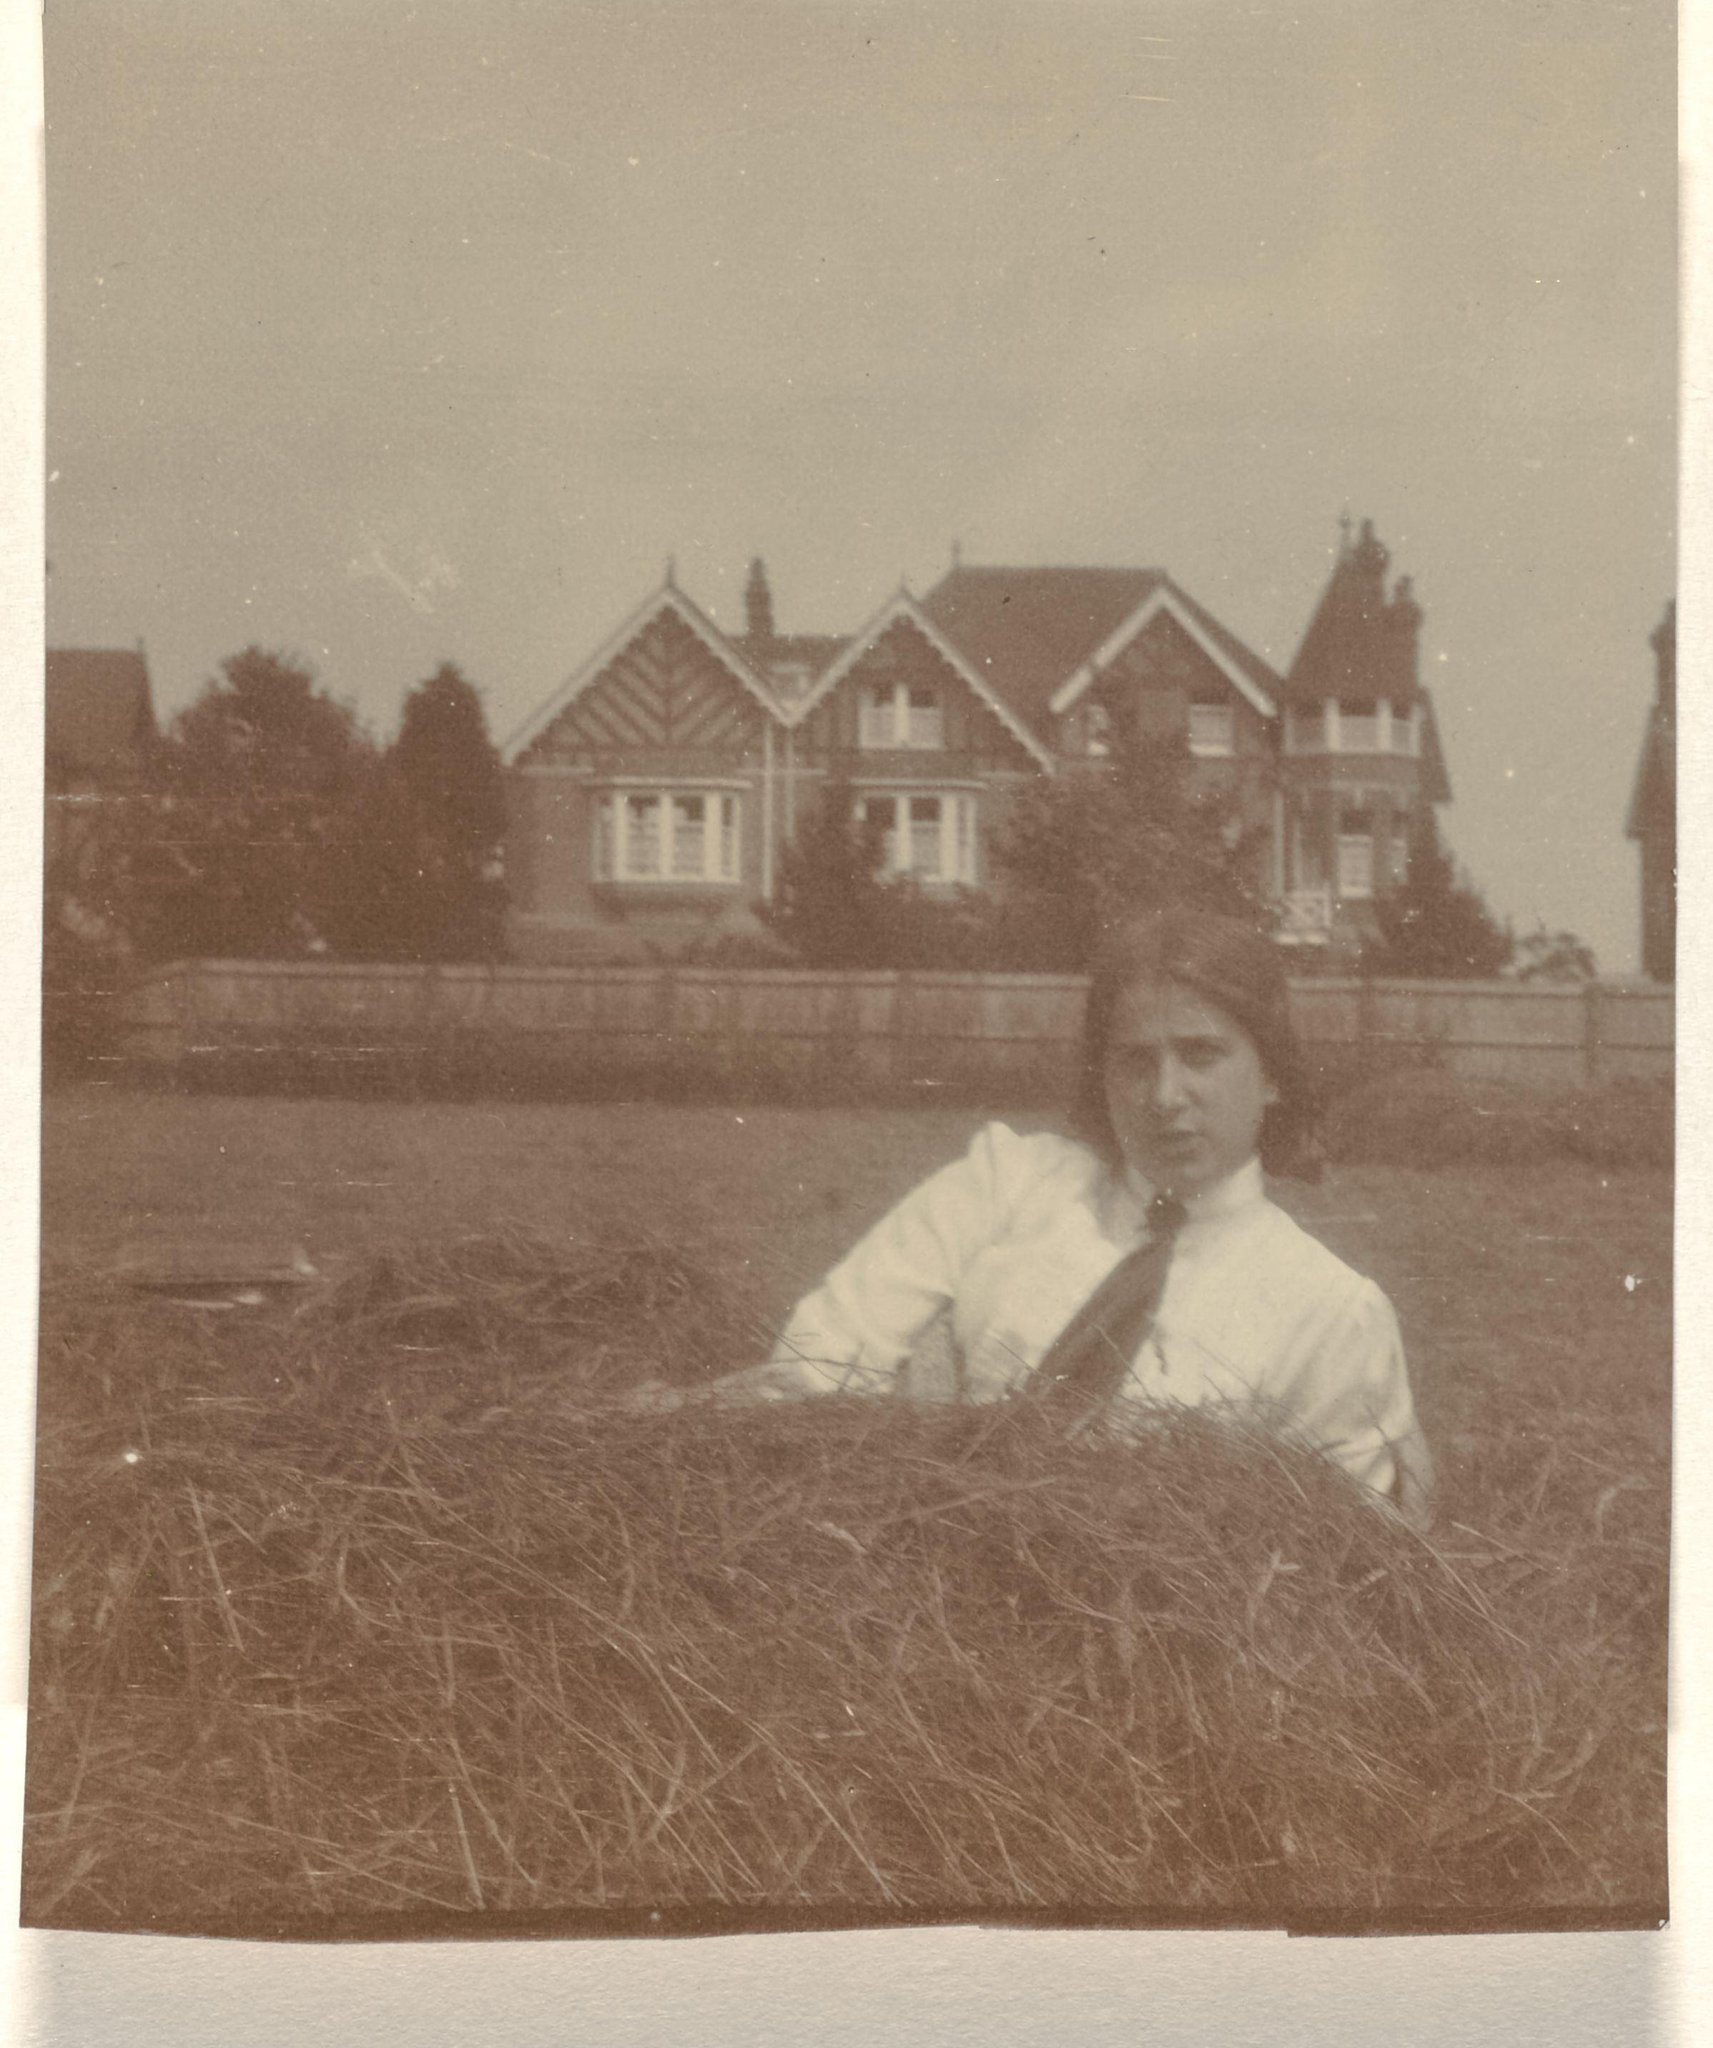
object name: photograph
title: Else Wachenheimer-Moos liggend in gras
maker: Anonymous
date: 1913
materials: photographic support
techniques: gelatin silver print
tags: else wachenheimer-moos, england